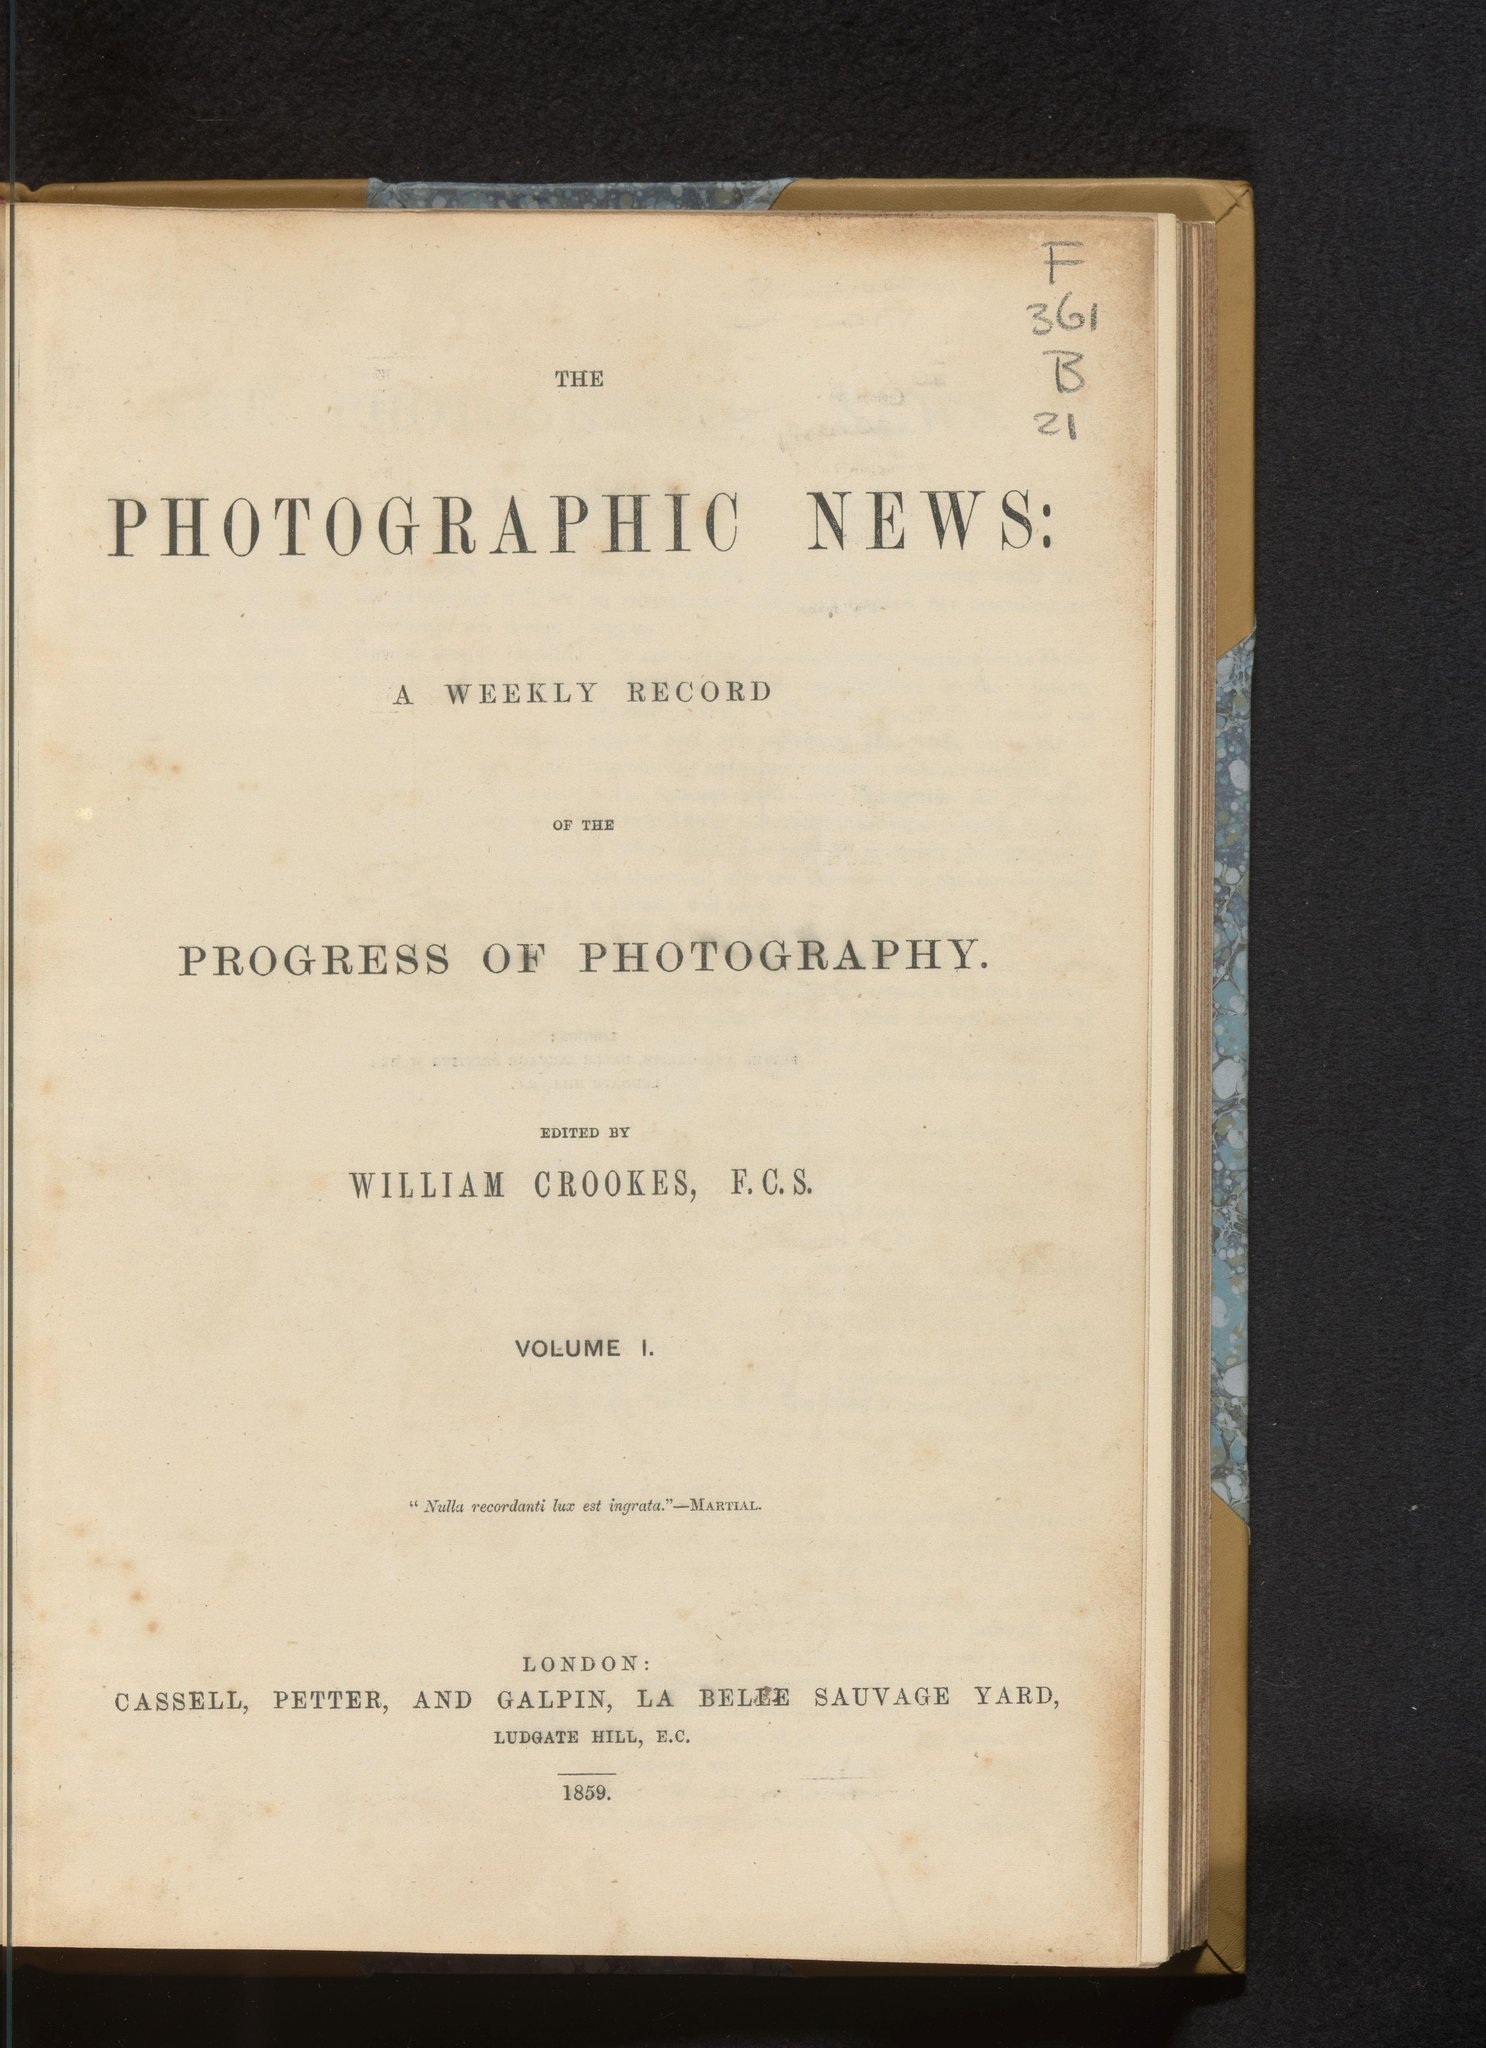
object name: book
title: The photographic news : a weekly record of the progress of photography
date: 1859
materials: cardboard, leather, paper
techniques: photoglyphic engraving, printing, marbling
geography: london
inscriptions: annotation: ‘DEC/1995’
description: Op pagina 25 staat een beschrijving van het proces van photoglyphic engraving.